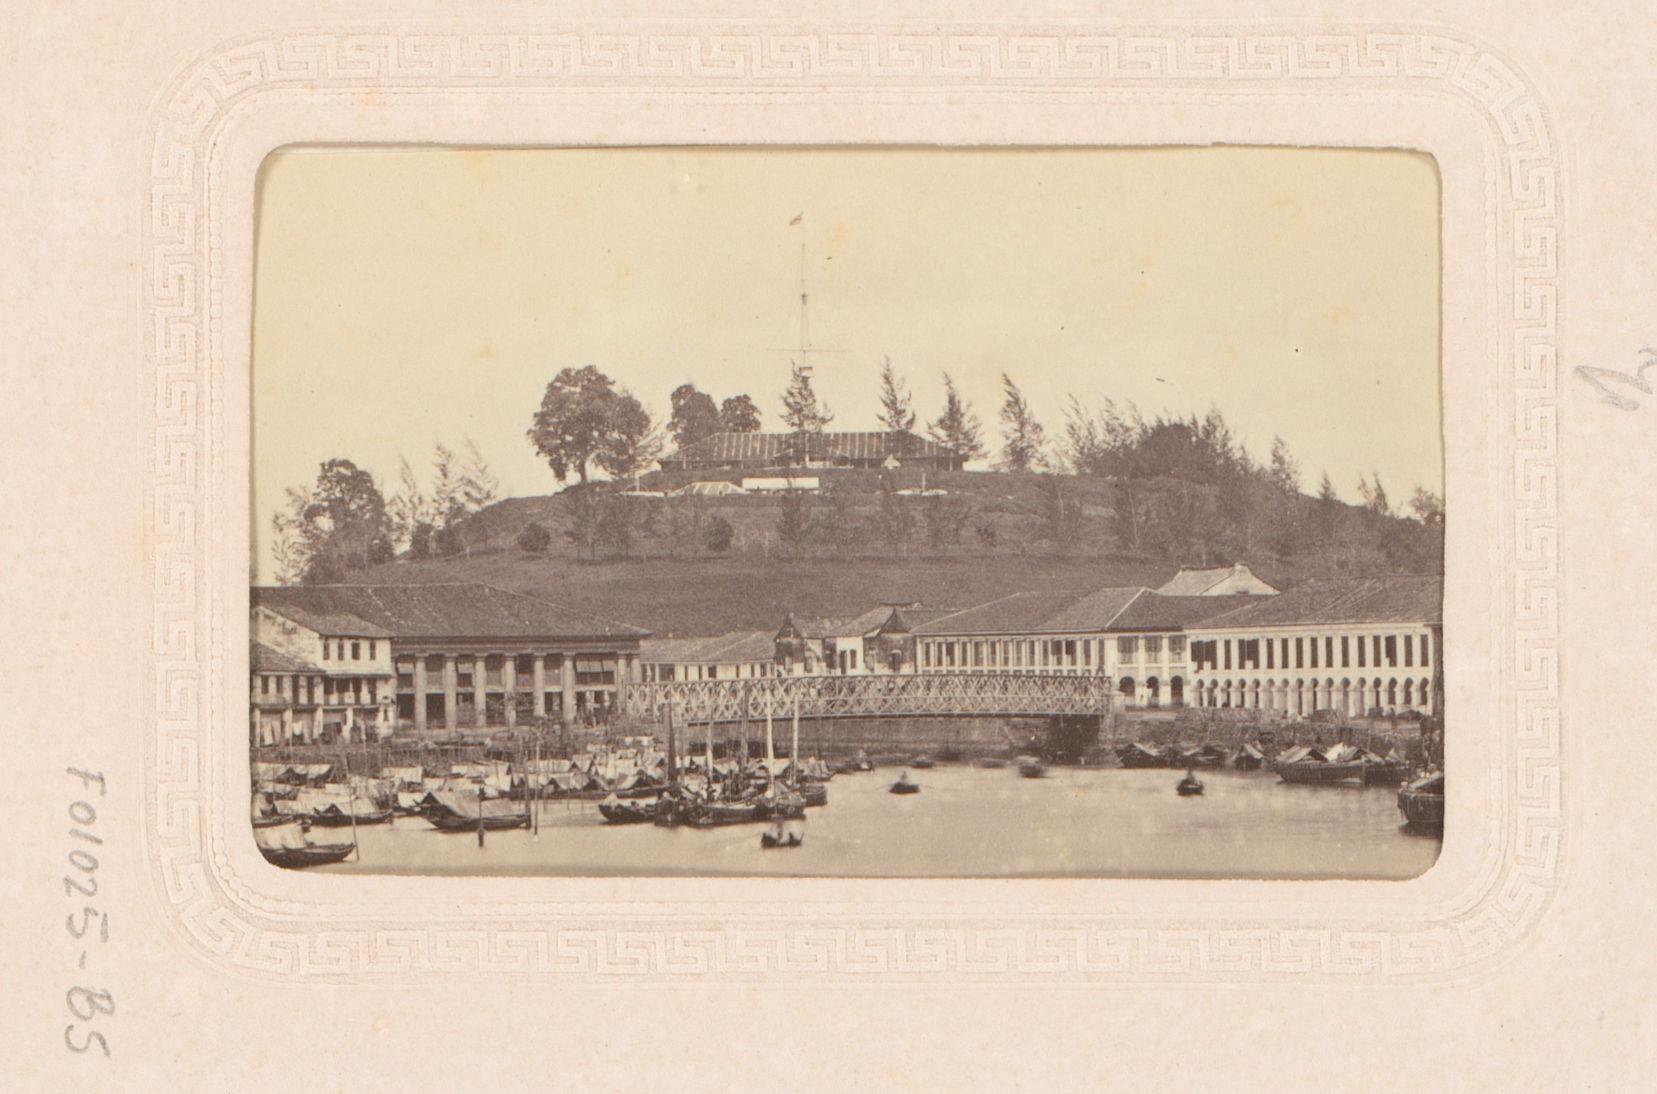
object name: carte de visite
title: Gezicht op Fort Canning met de Singapore River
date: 1867-1880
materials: cardboard, photographic support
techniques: albumen print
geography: singapore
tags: fortress, river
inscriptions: number: ‘71’, annotation: ‘The Boat Quai en Fot Canning/ Singapore’, inscription: ‘G.R. Lambert & Co./ Photographers/ Singapore’